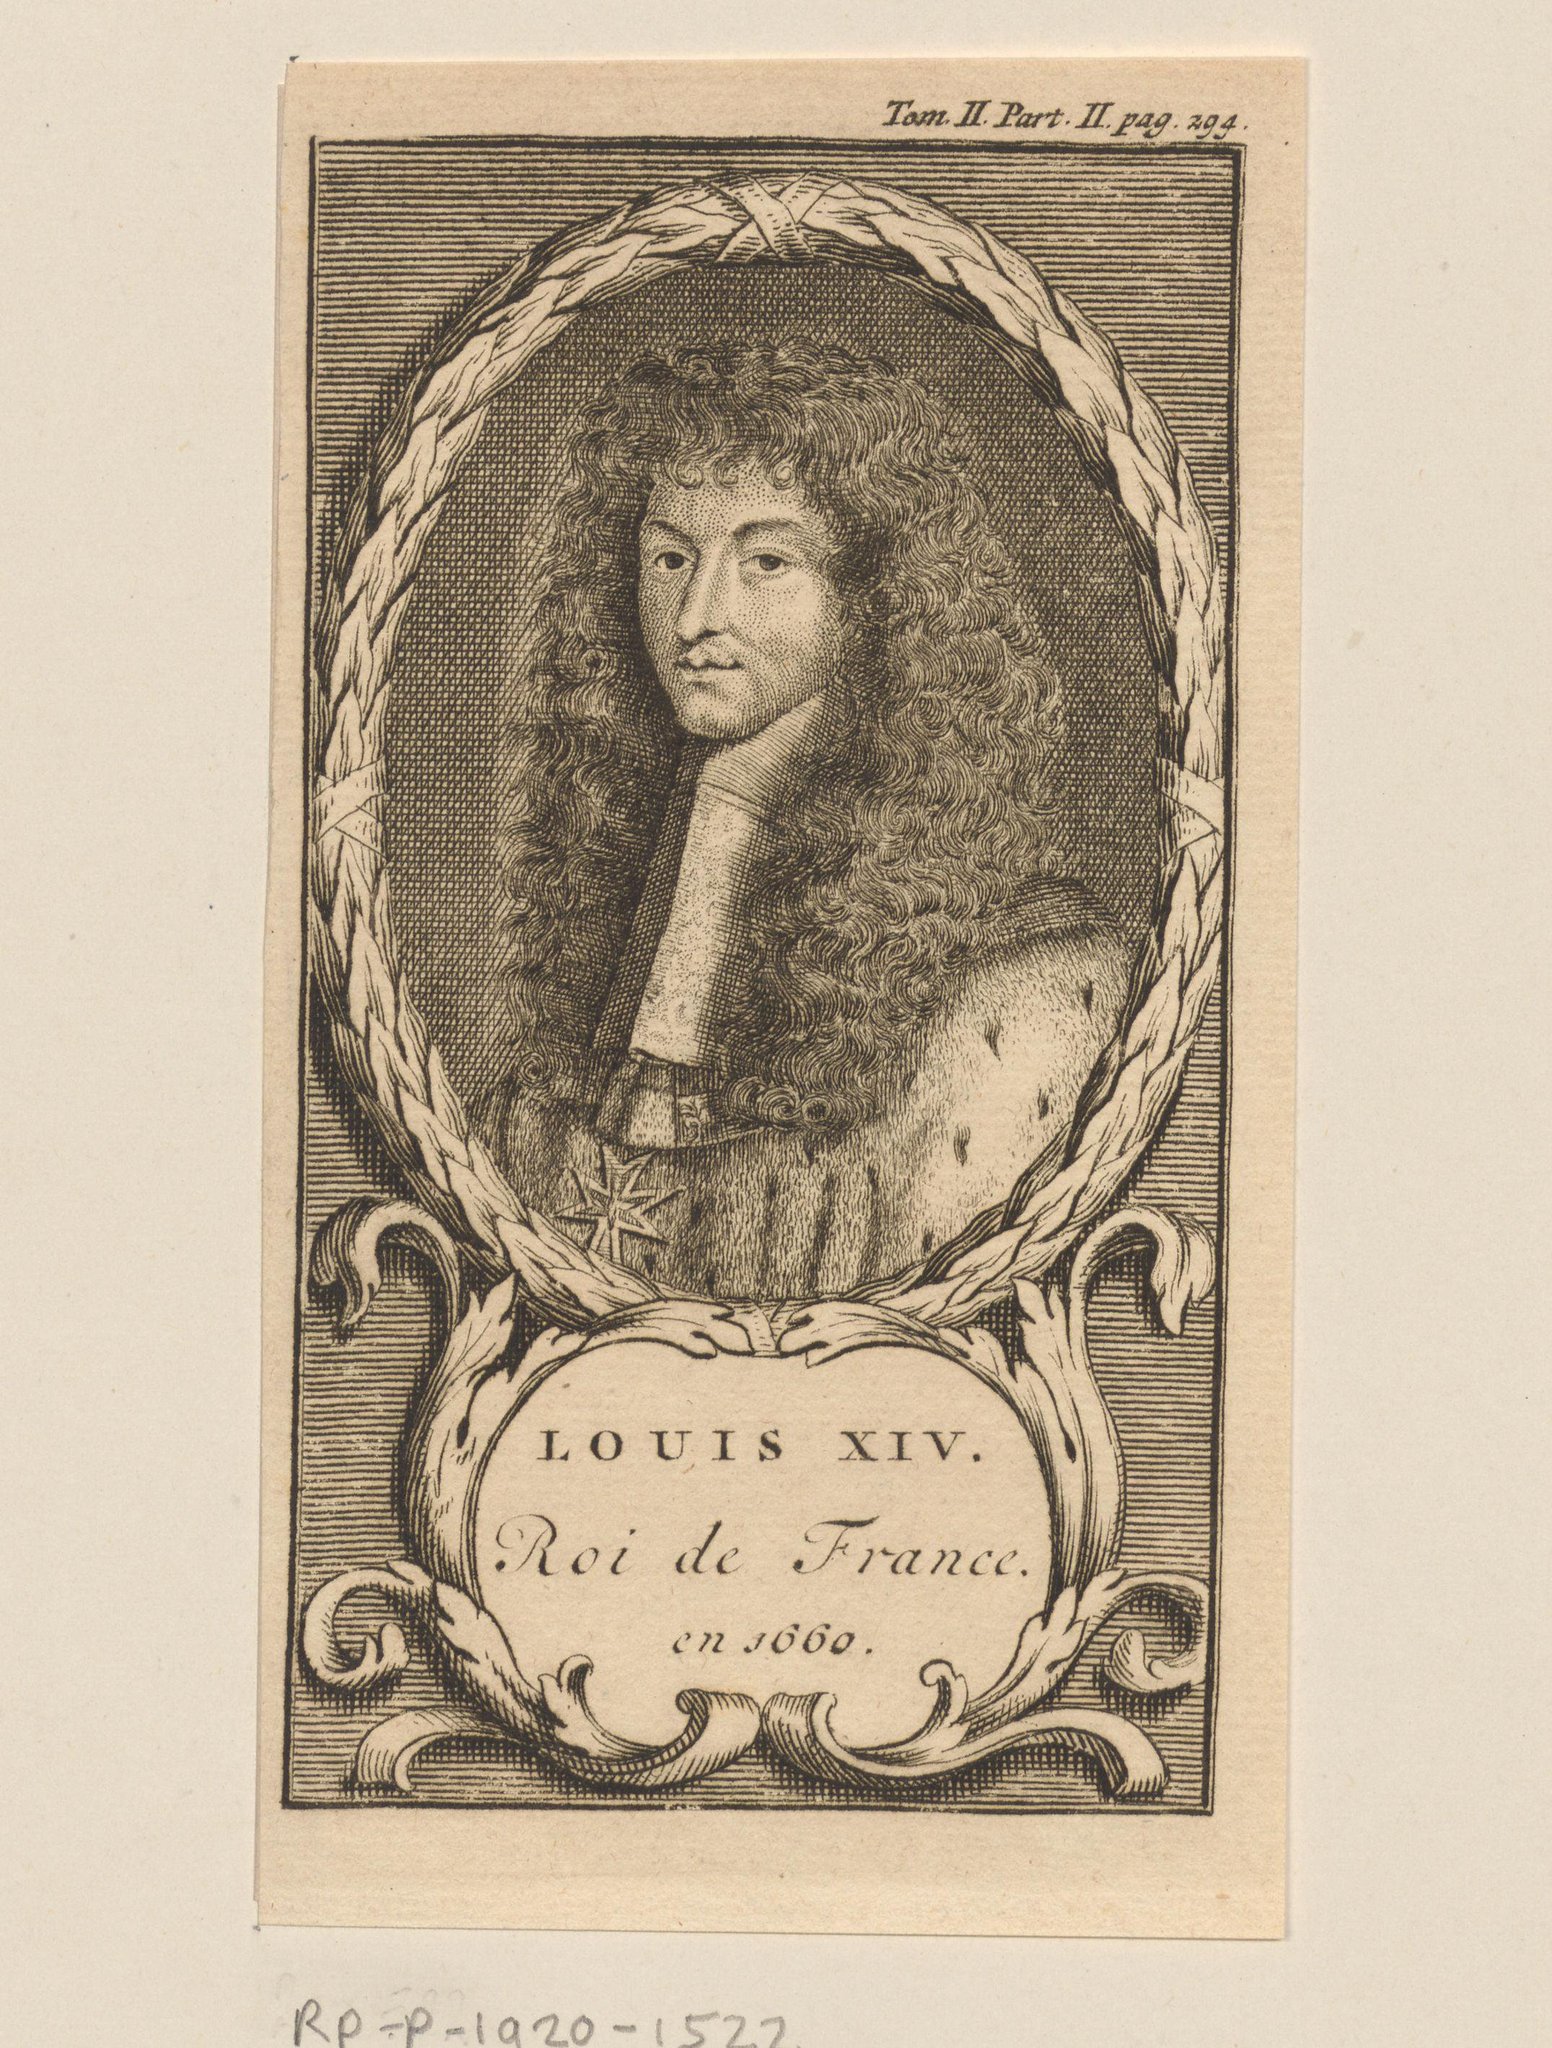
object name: book illustration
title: Portret van Lodewijk XIV van Frankrijk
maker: Anonymous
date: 1718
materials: paper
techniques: engraving, etching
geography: northern netherlands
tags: lodewijk xiv (koning van frankrijk), historical persons, king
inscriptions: collector's mark: Lugt 2228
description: Prent waarschijnlijk uit: Limiers, Henri P. de. Histoire du Regne de Louis XIV (...). Amsterdam: La Compagnie, 1718, dl. 2.